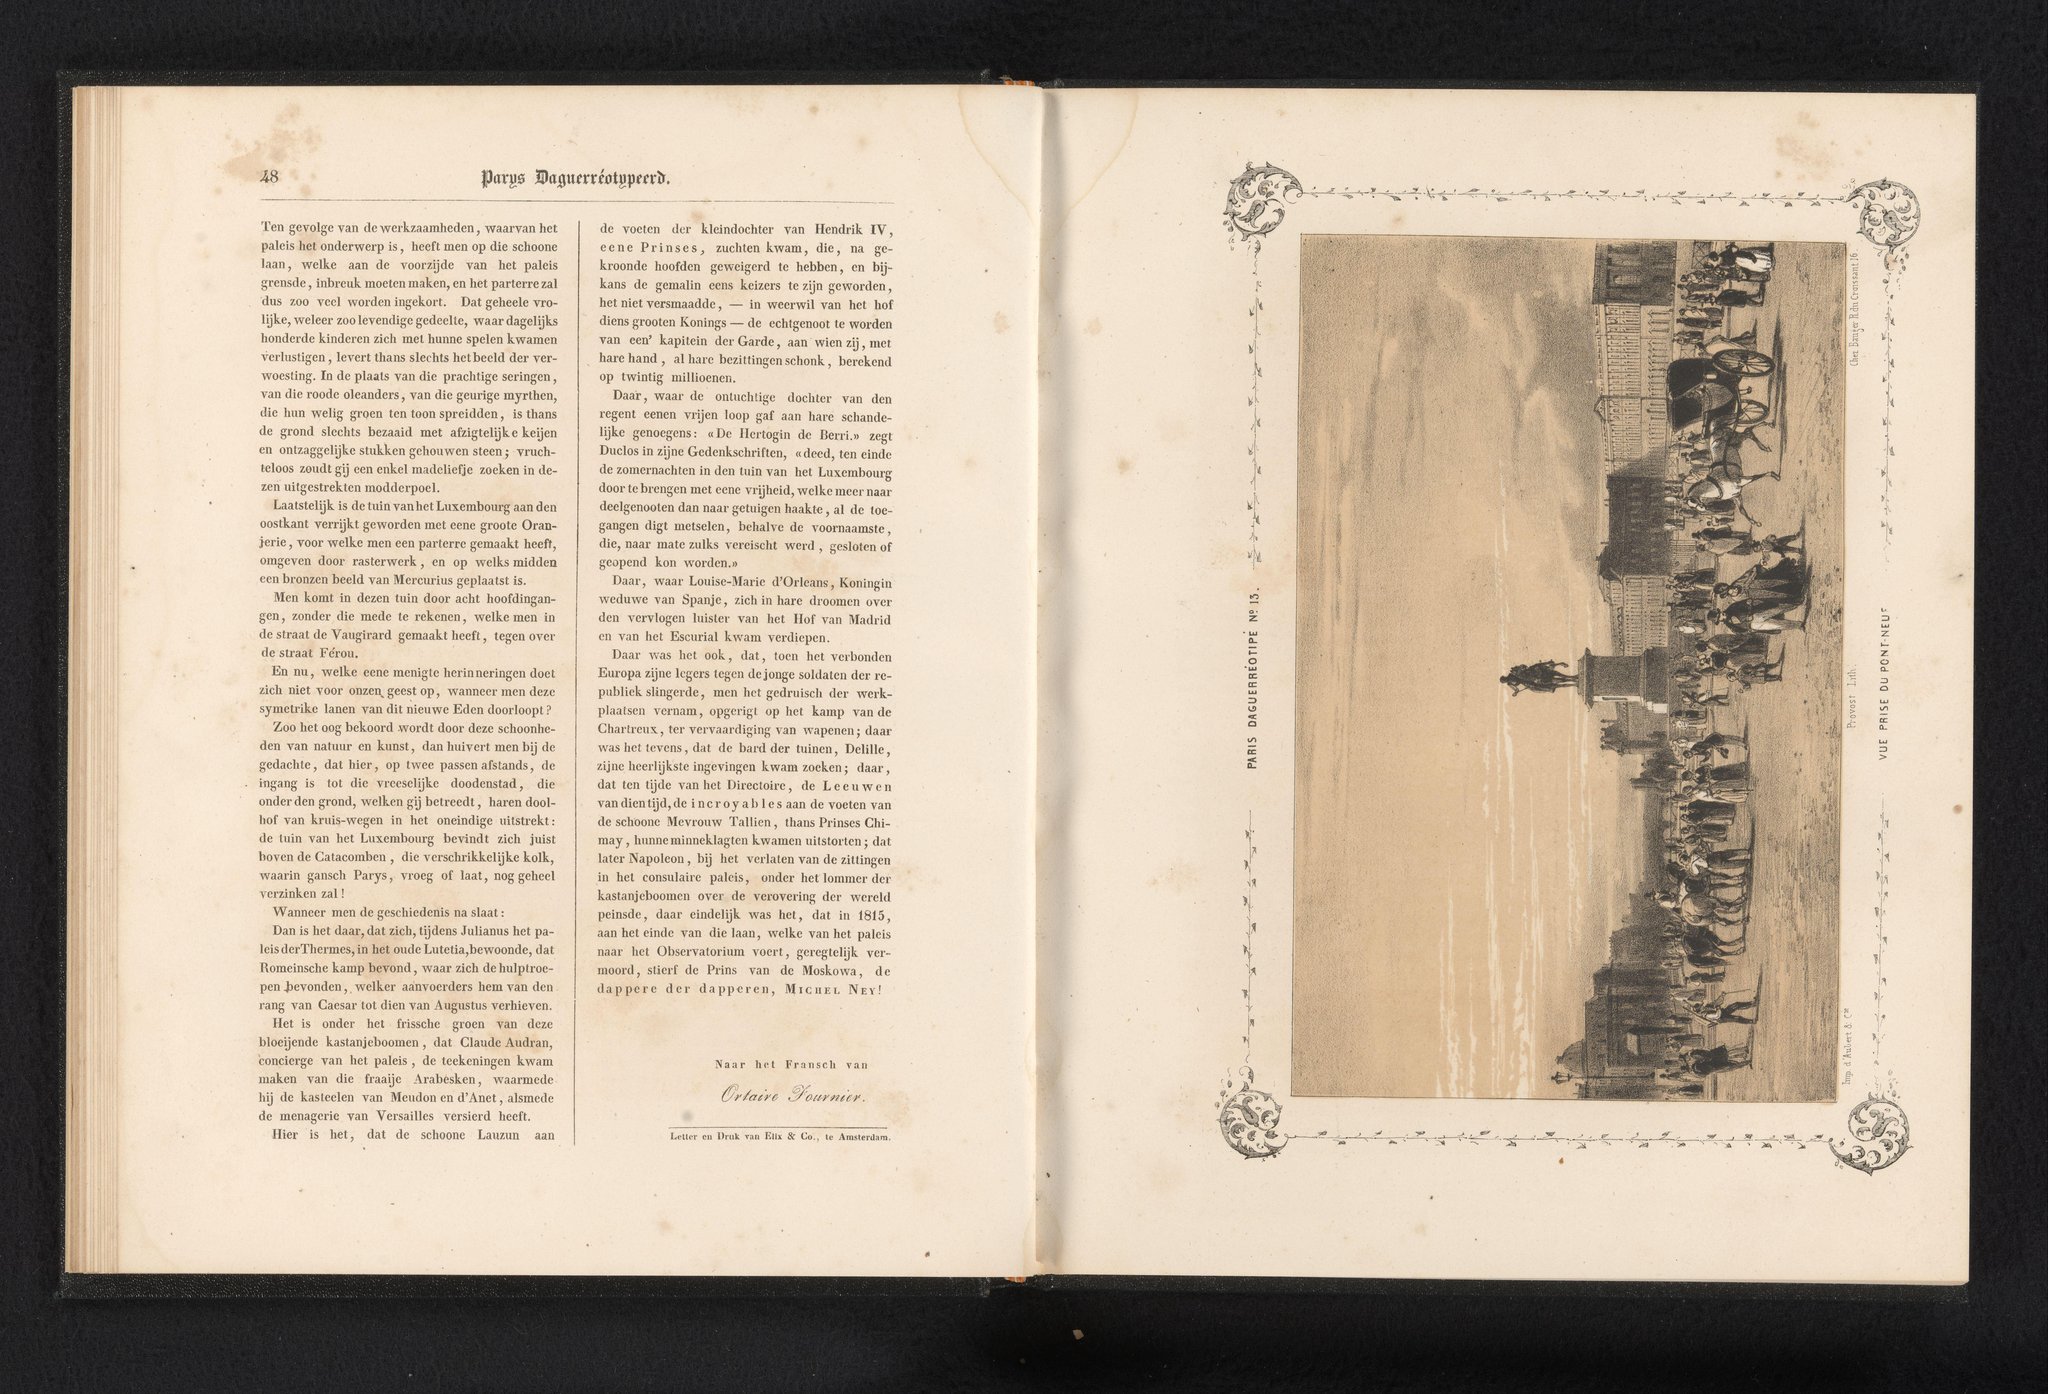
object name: page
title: Parijs gezien vanaf de Pont Neuf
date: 1839-1840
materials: paper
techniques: tone lithography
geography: paris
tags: city-view in general; 'veduta'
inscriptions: inscription: ‘PARIS DAGUERRÉOTYPÉ No. 13.’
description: Prent op negenenveertigste ongenummerde pagina.